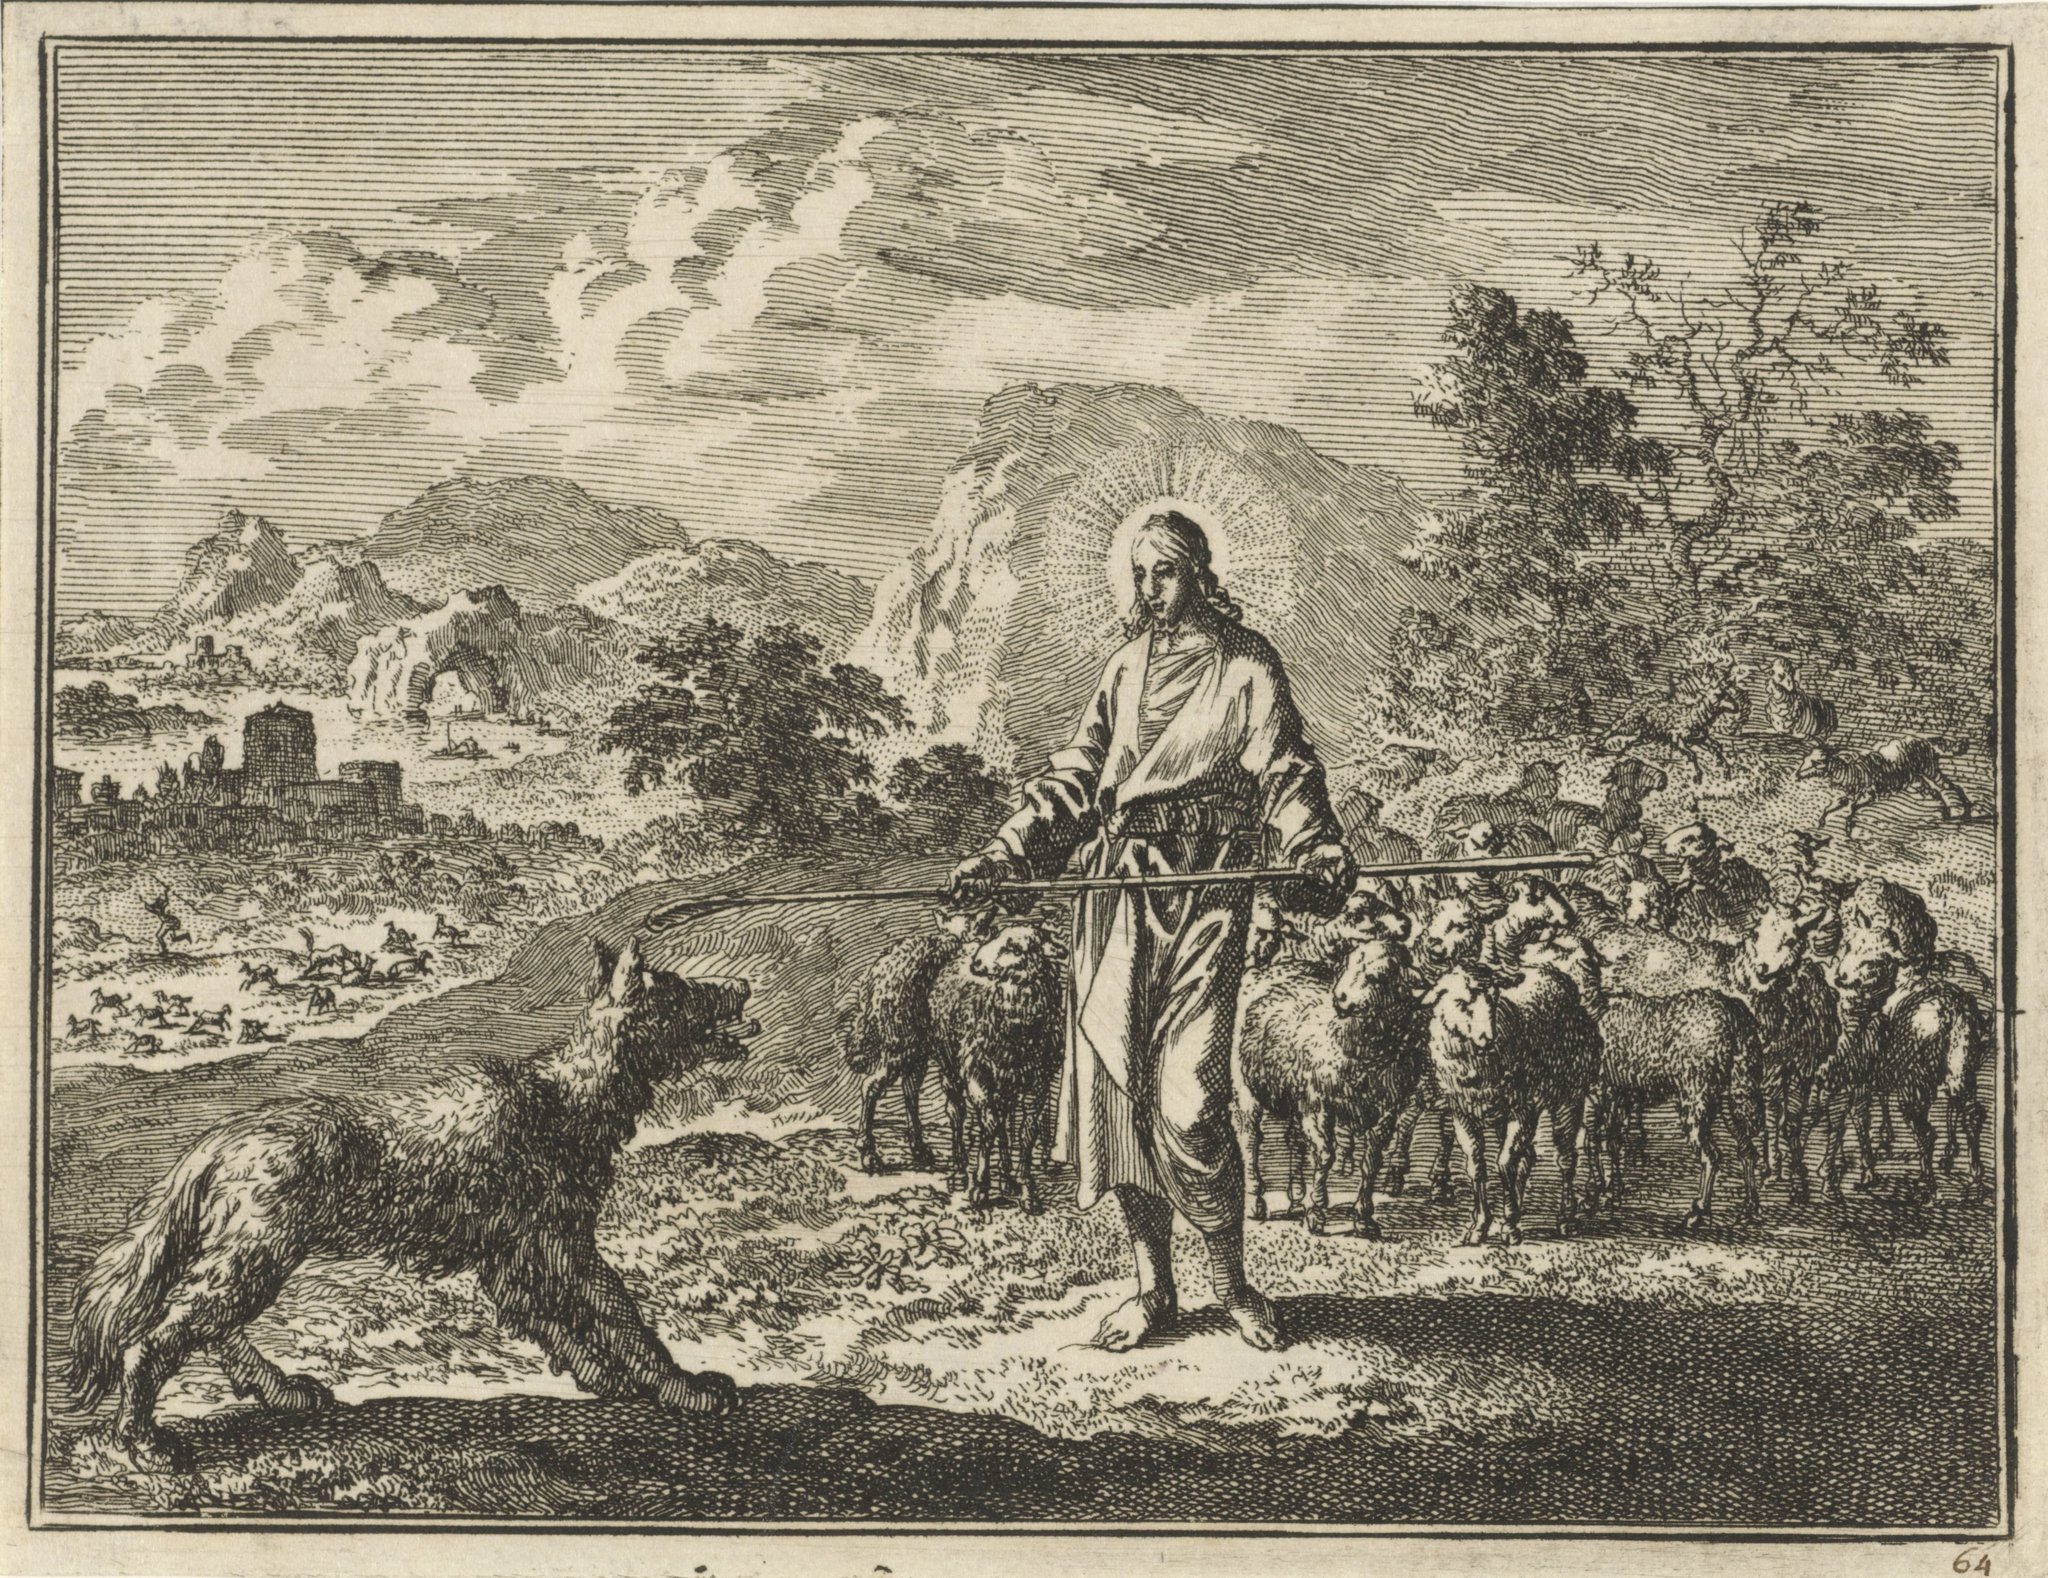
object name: print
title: Christus als de Goede Herder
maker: jan luyken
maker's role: draughtsman, print maker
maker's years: 1649-1712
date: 1712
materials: paper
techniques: etching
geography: amsterdam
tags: the good shepherd (christ) defending his sheep against wolves; 'i am the good shepherd' (john 10:1-16)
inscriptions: number: ‘64’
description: Proefdruk van illustratie uit: Luyken, Jan. De schriftuurlyke geschiedenissen en gelykenissen van het Oude en Nieuwe Verbond, 2 delen. Amsterdam: Wed. Pieter Arentsz II en Cornelis van der Sys, 1712, dl. II.